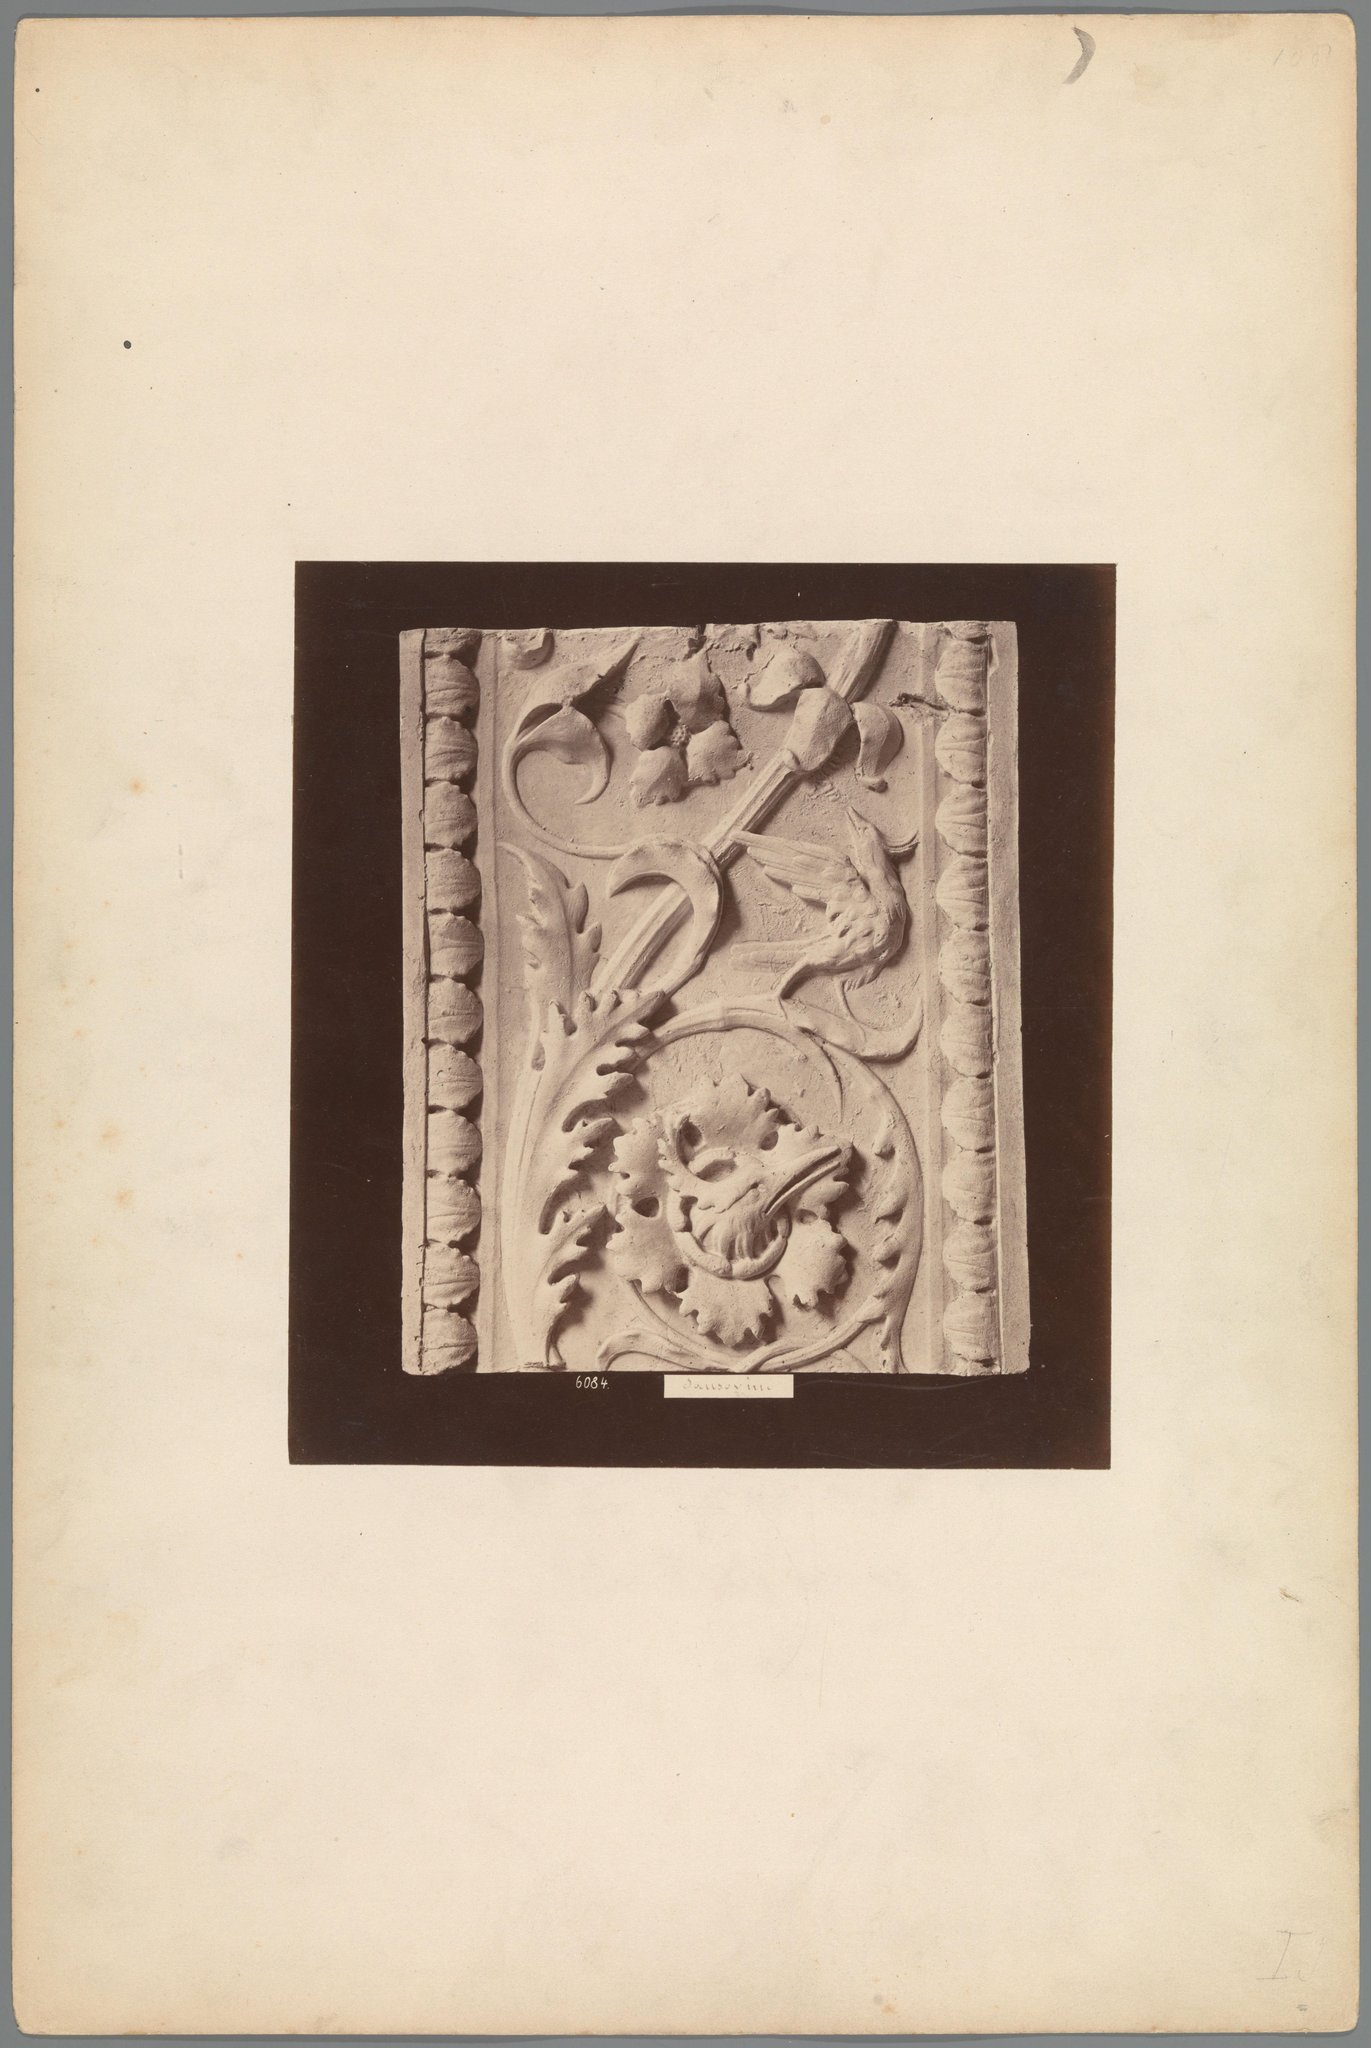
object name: photograph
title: Sansovino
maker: Anonymous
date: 1875-1900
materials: cardboard, photographic support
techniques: albumen print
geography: europe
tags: ornamental birds, acanthus ~ ornament, sculpture (+ relief ~ sculpture), europe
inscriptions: number: ‘6084.’, collector's mark: Lugt 3937